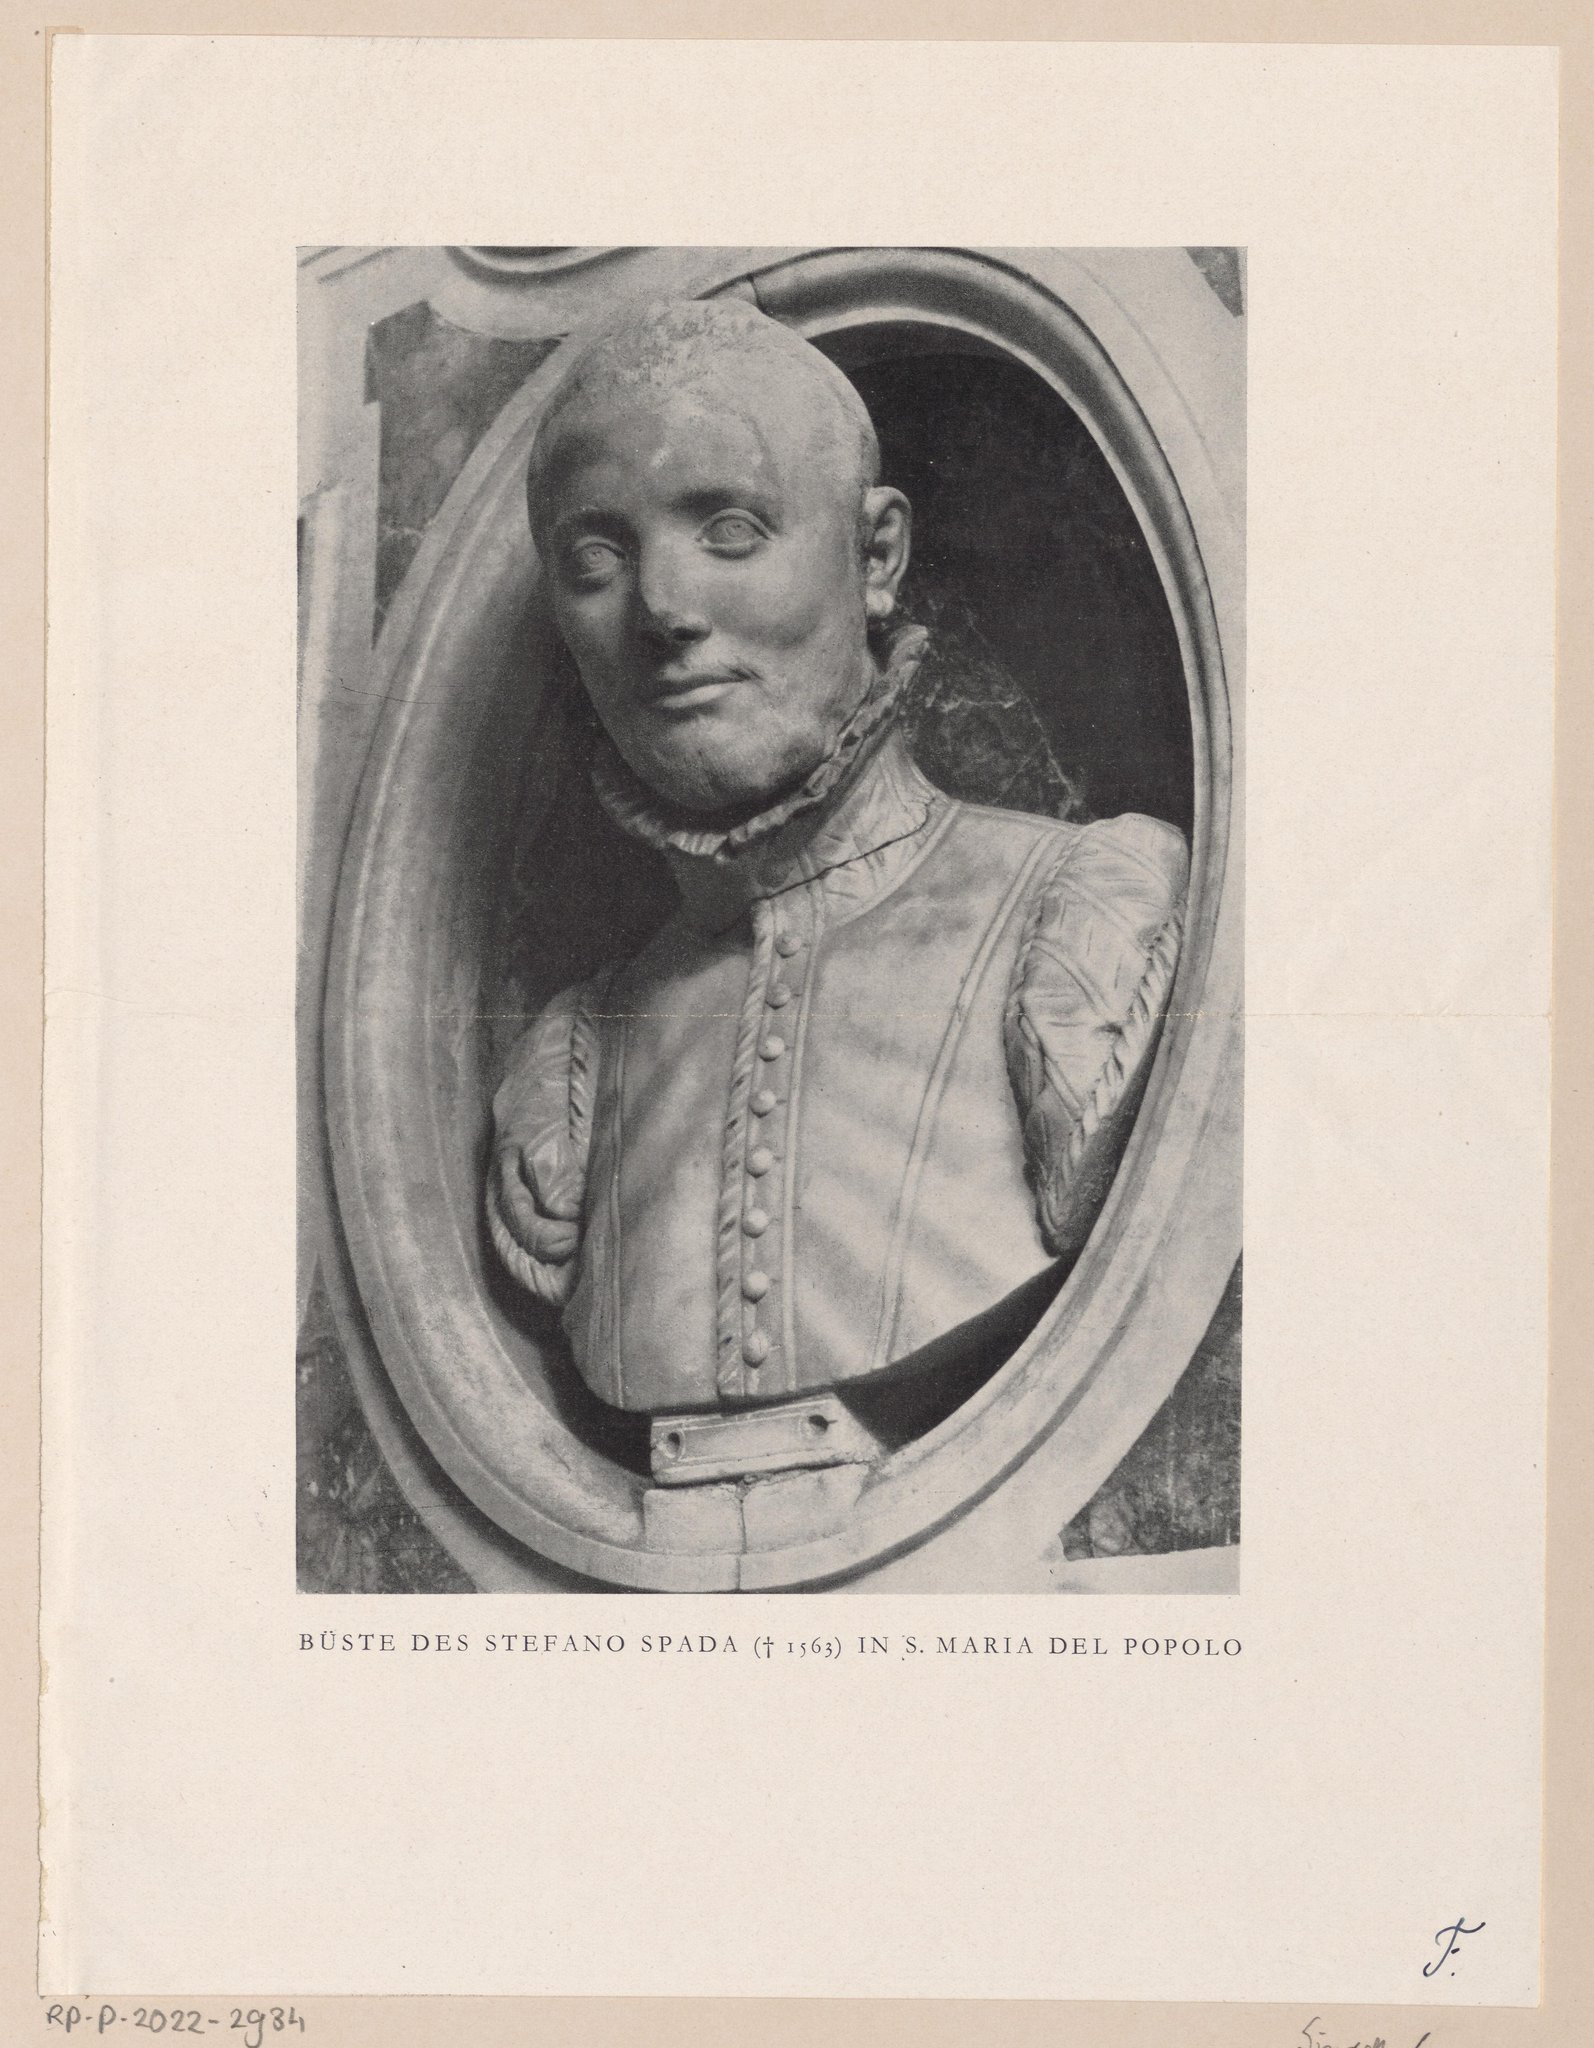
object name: photomechanical print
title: Portretbuste van Stefano Spada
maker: Anonymous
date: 1882-1970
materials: paper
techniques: letterpress printing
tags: historical persons, grave-building, monumental tomb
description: Fotomechanische afdruk uit een onbekende publicatie.